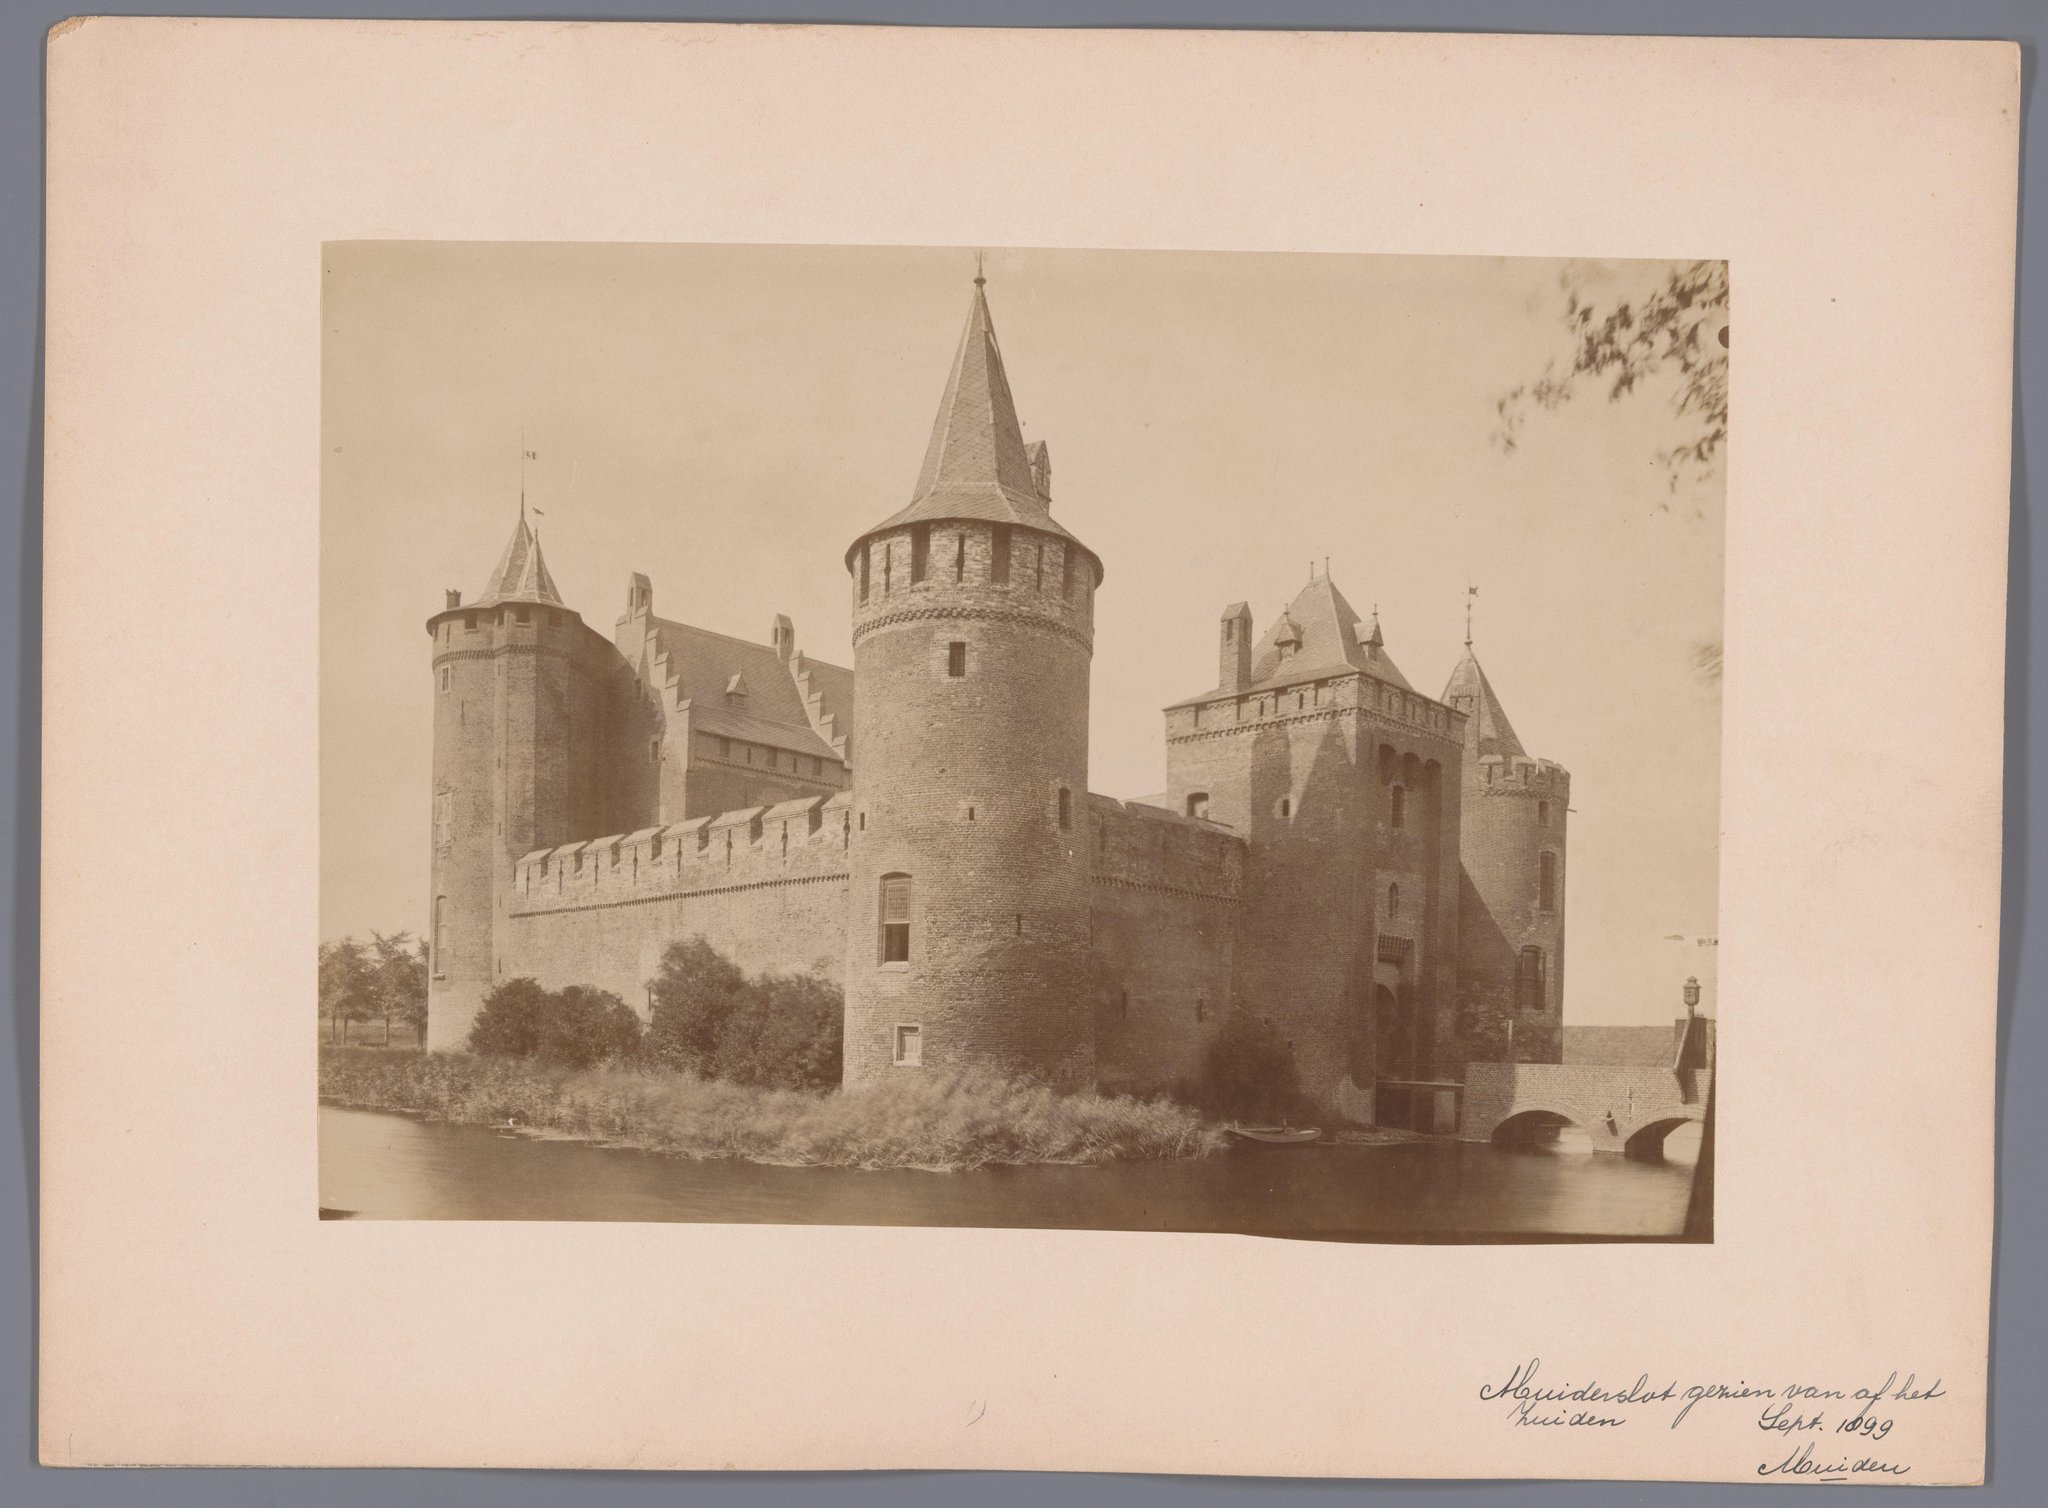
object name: photograph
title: Gezicht op het Muiderslot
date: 1899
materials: cardboard, photographic support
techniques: albumen print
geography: muiden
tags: castle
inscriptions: annotation: ‘Muiderslot gezien van af het zuiden Sept. 1899/ Muiden’, annotation: ‘Slot te Muiden (N.H.)/ gezien van af het zuiden/ Sept 1899’